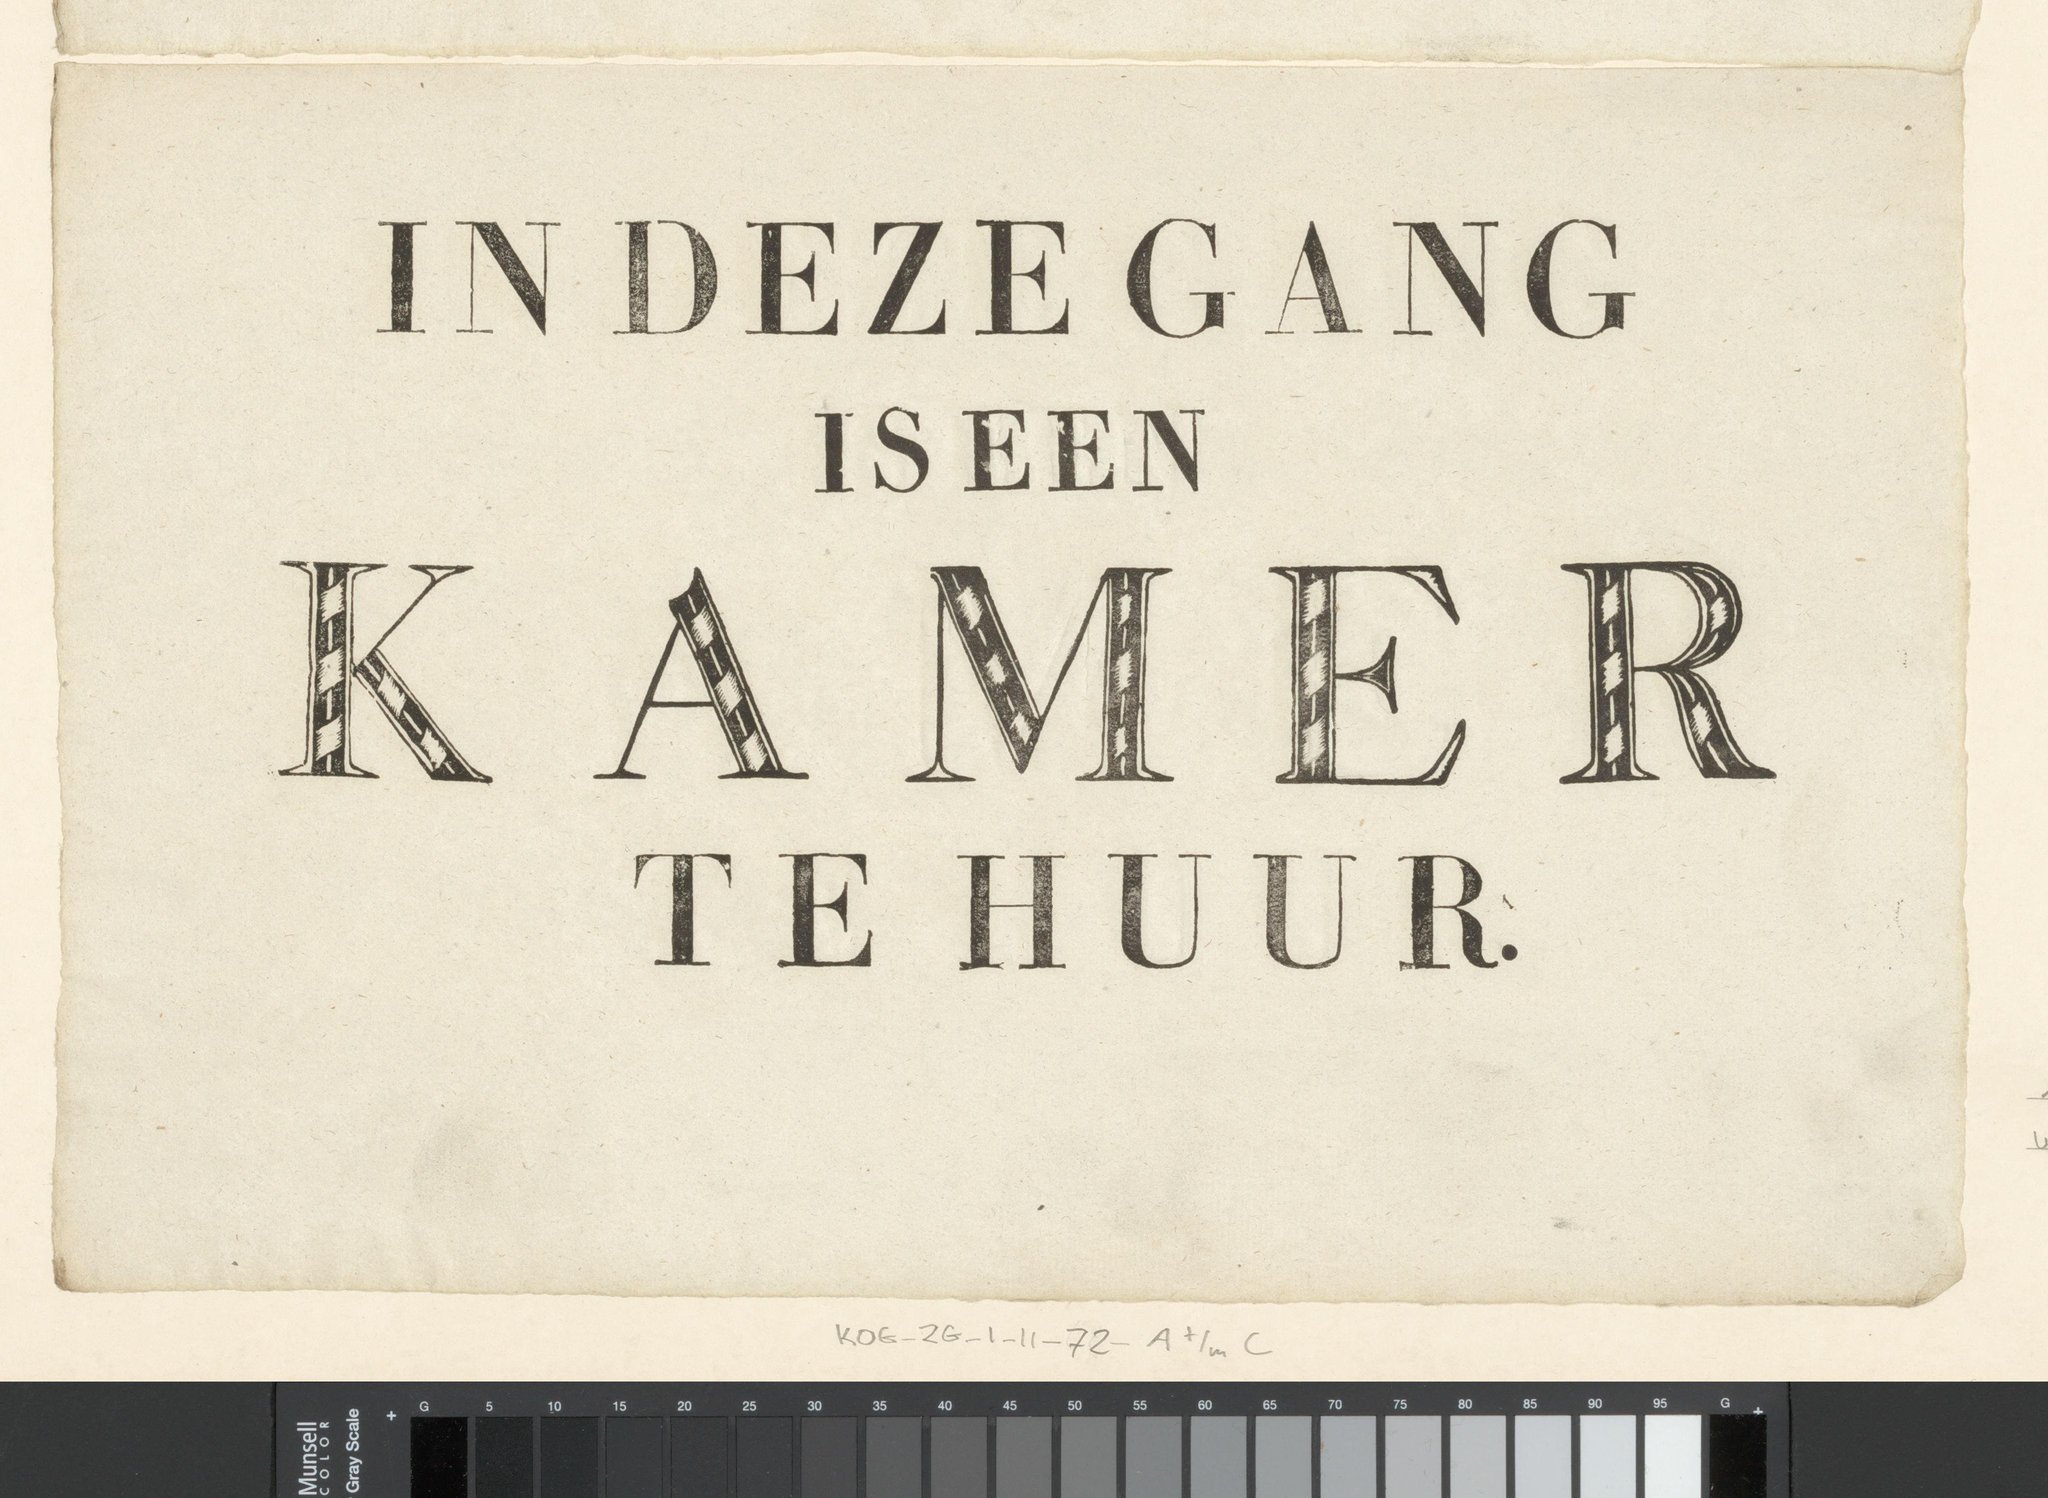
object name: text sheet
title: Aankondiging van kamer die te huur staat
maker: Anonymous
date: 1700-1799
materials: paper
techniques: letterpress printing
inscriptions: stamp, collector's mark: Lugt 1641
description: Onderwerpsrubrieken binnen de Atlas Zeden en Gewoonten: Handel, nijverheid en verkeer, Koophandel, Veilingen, Makelaardij en Verzekeringswezen. Kamers te huur.